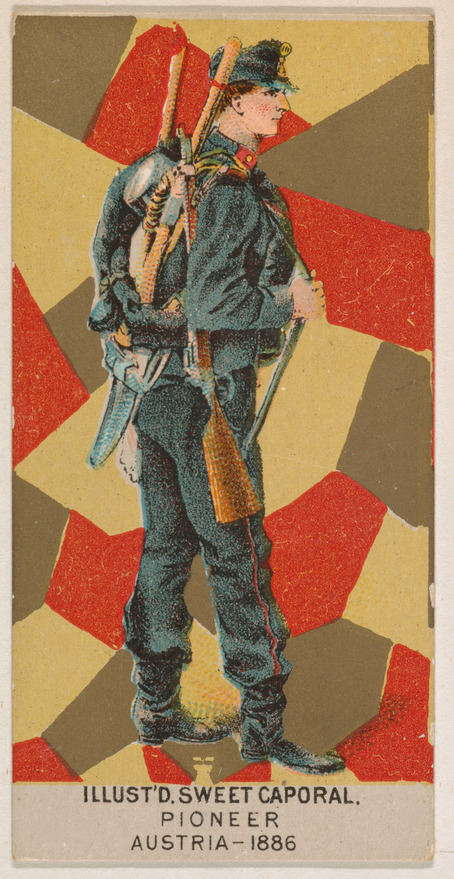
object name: print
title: Pioneer, Austria, 1886, from the Military Series (N224) issued by Kinney Tobacco Company to promote Sweet Caporal Cigarettes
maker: kinney brothers tobacco company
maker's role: publisher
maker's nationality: american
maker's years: 1869-2011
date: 1888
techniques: color lithograph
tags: military,men